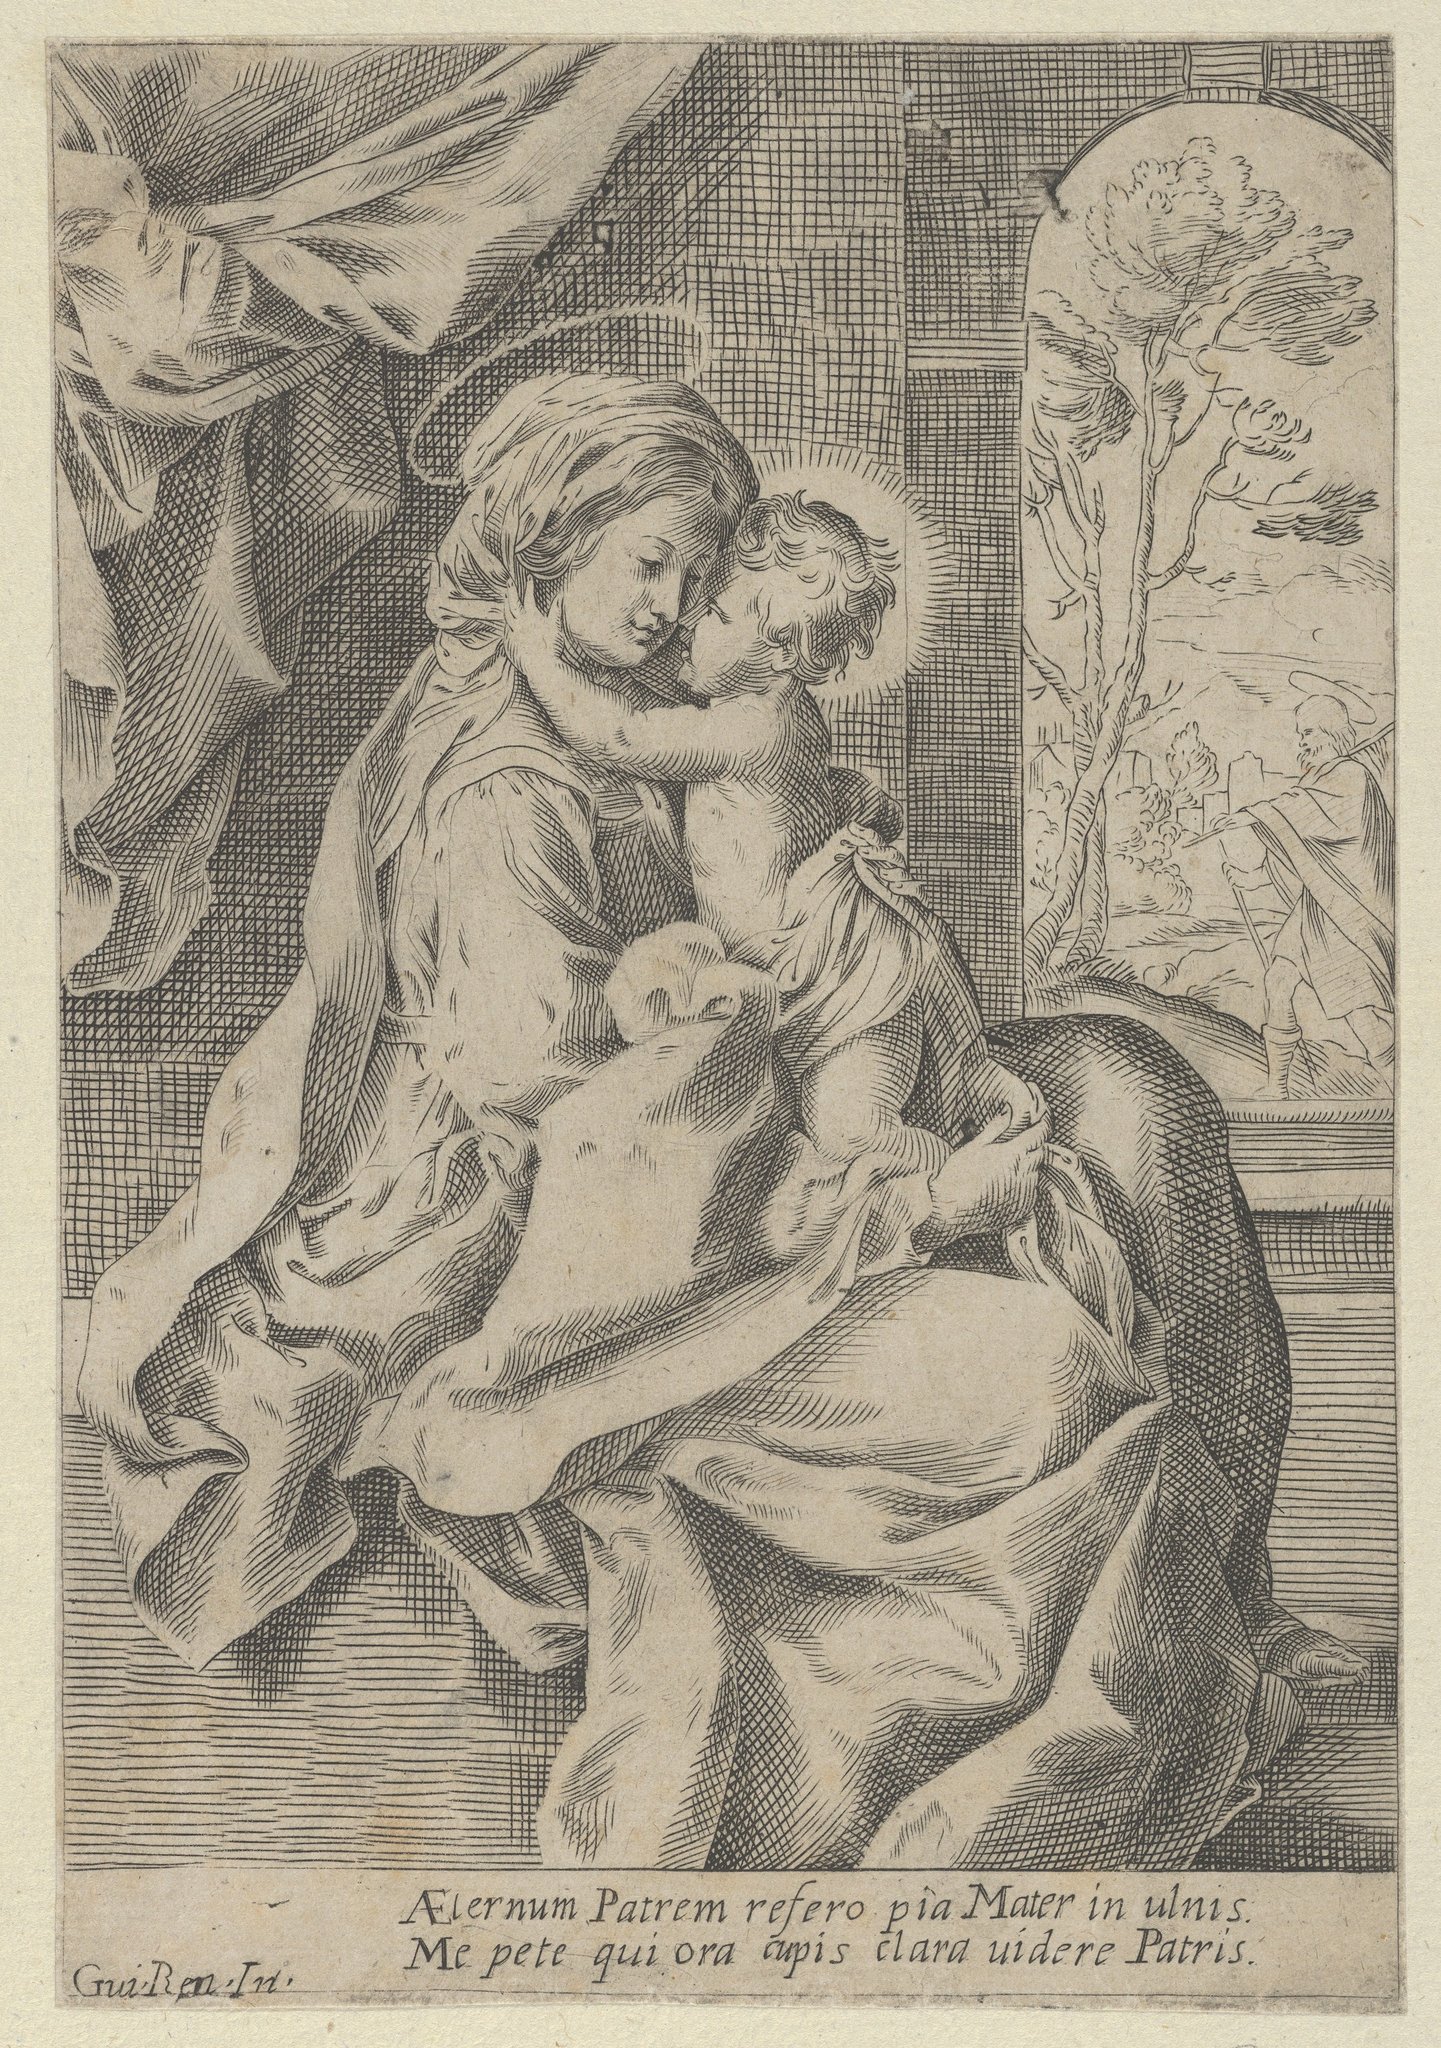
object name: print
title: The Virgin seated with the Christ Child on her lap embracing her, St Joseph seen through an archway at right, after Reni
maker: anonymous, 17th century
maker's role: artist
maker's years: 1600-1700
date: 1600-1640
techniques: etching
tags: love,madonna and child